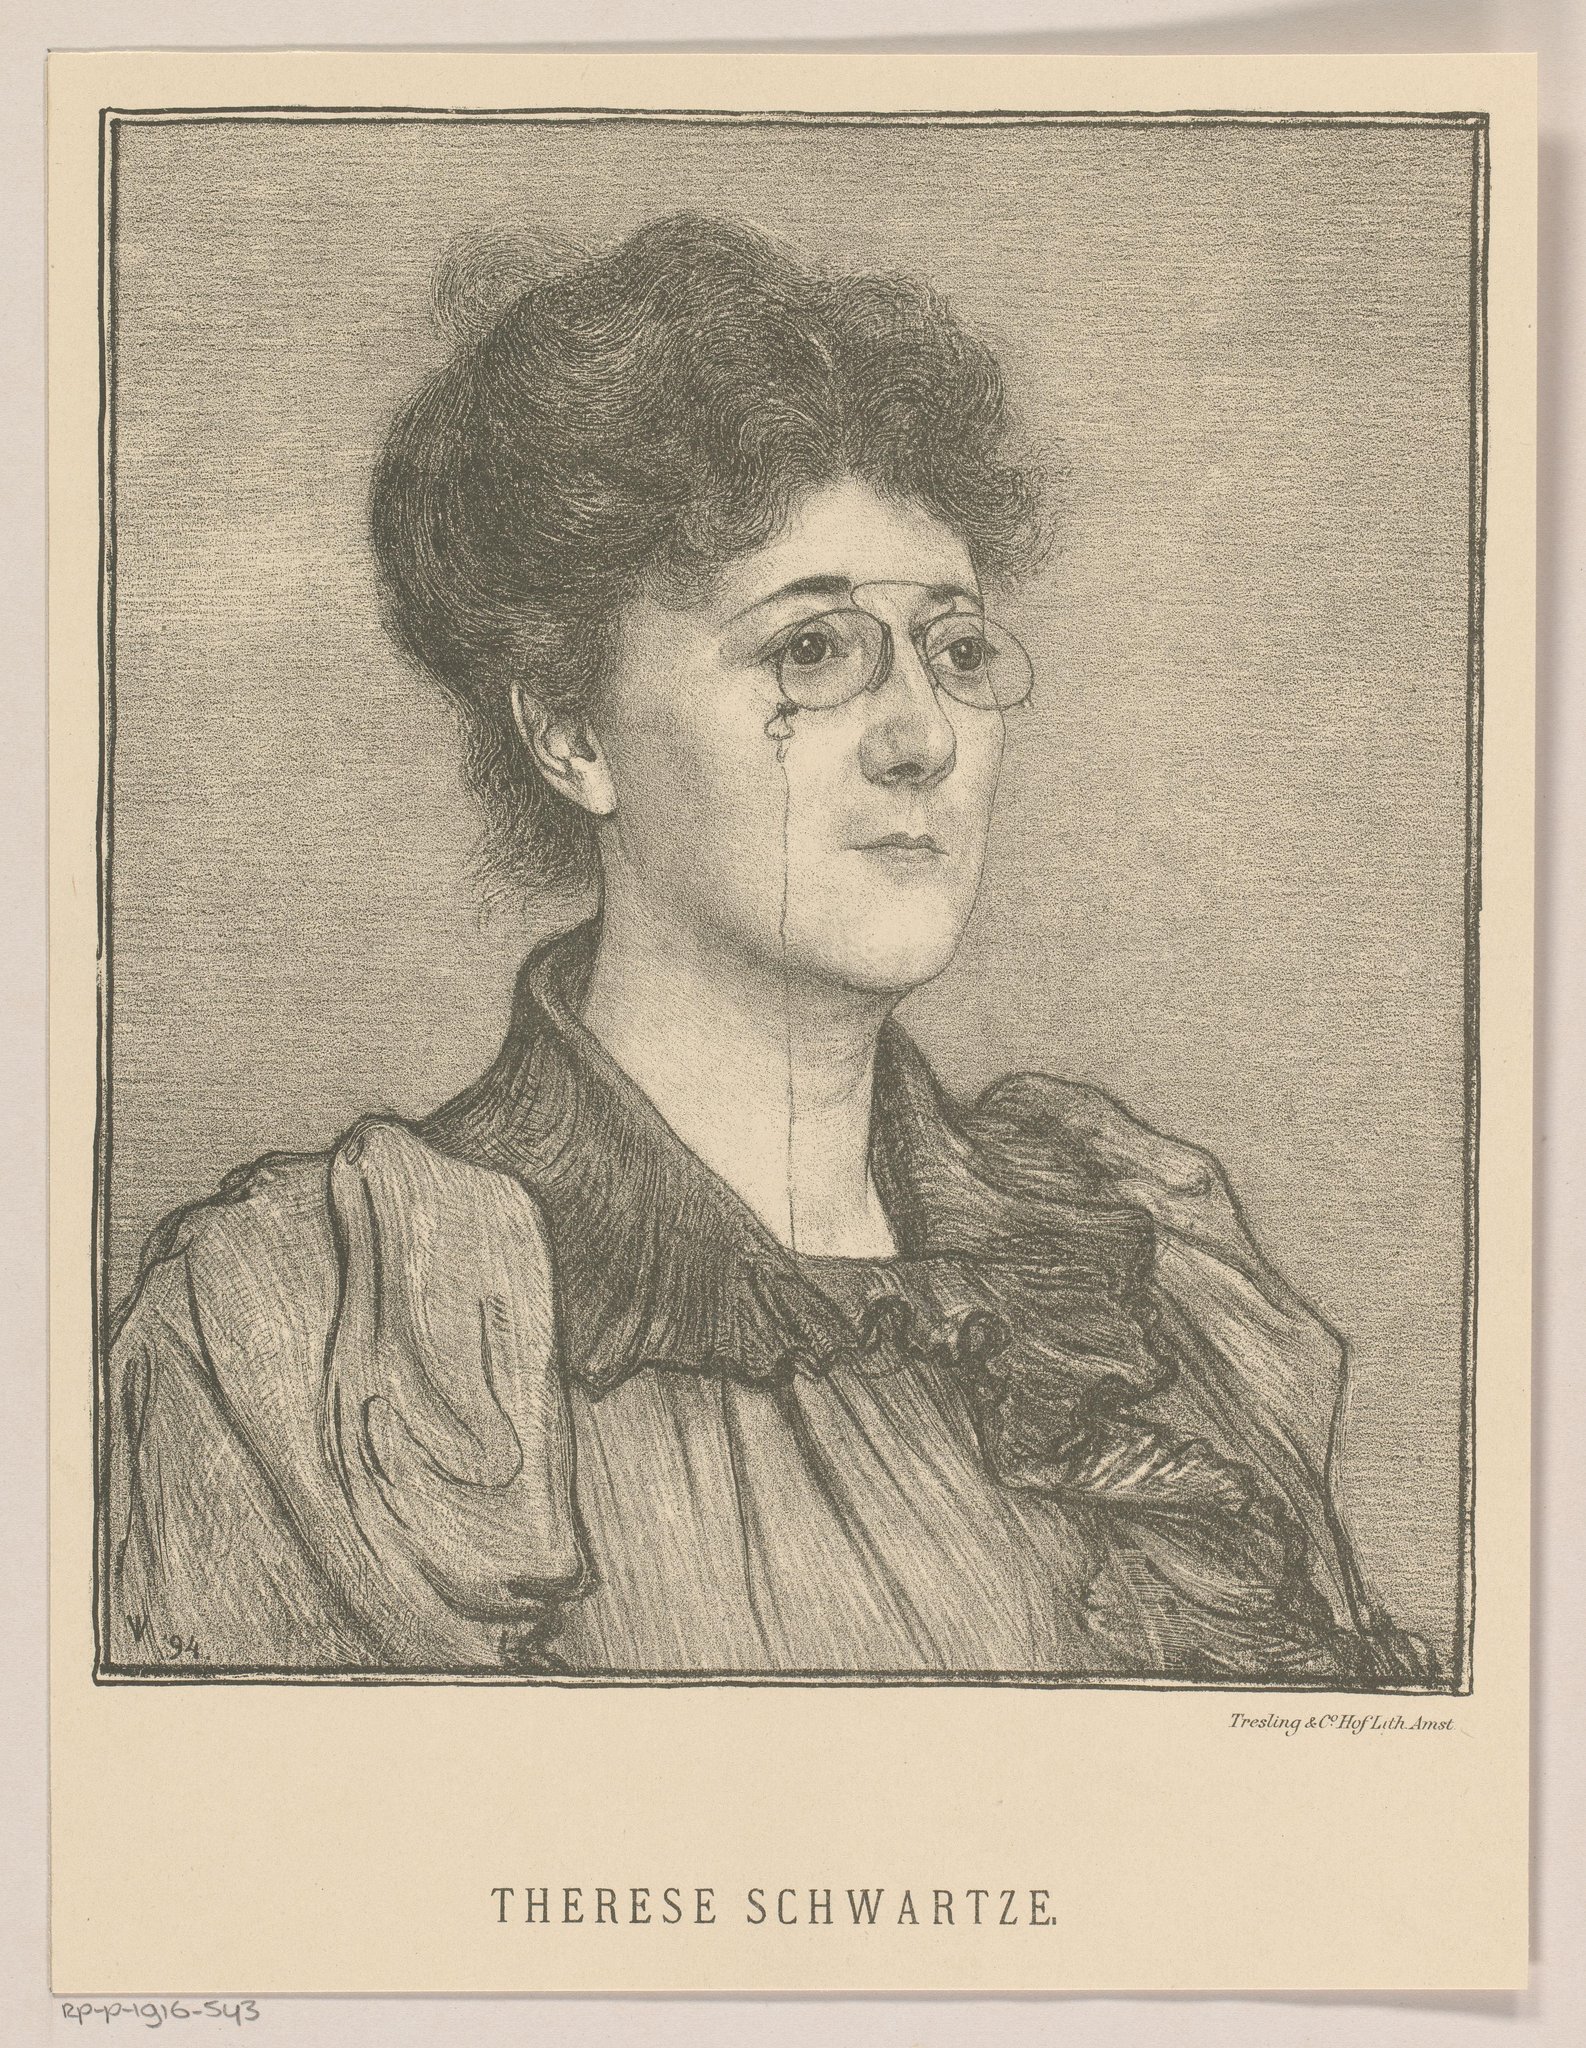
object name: print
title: Bekende tijdgenooten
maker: jan veth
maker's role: designer, draughtsman, painter, print maker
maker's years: 1864-1925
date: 1894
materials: paper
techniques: lithograph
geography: amsterdam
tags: amsterdam, draughtsman, thérèse schwartze, historical persons, portrait, self-portrait of artist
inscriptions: collector's mark: Lugt 2228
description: Deze prent werd uitgegeven als bijvoegsel van De Amsterdammer op 4 november 1894.